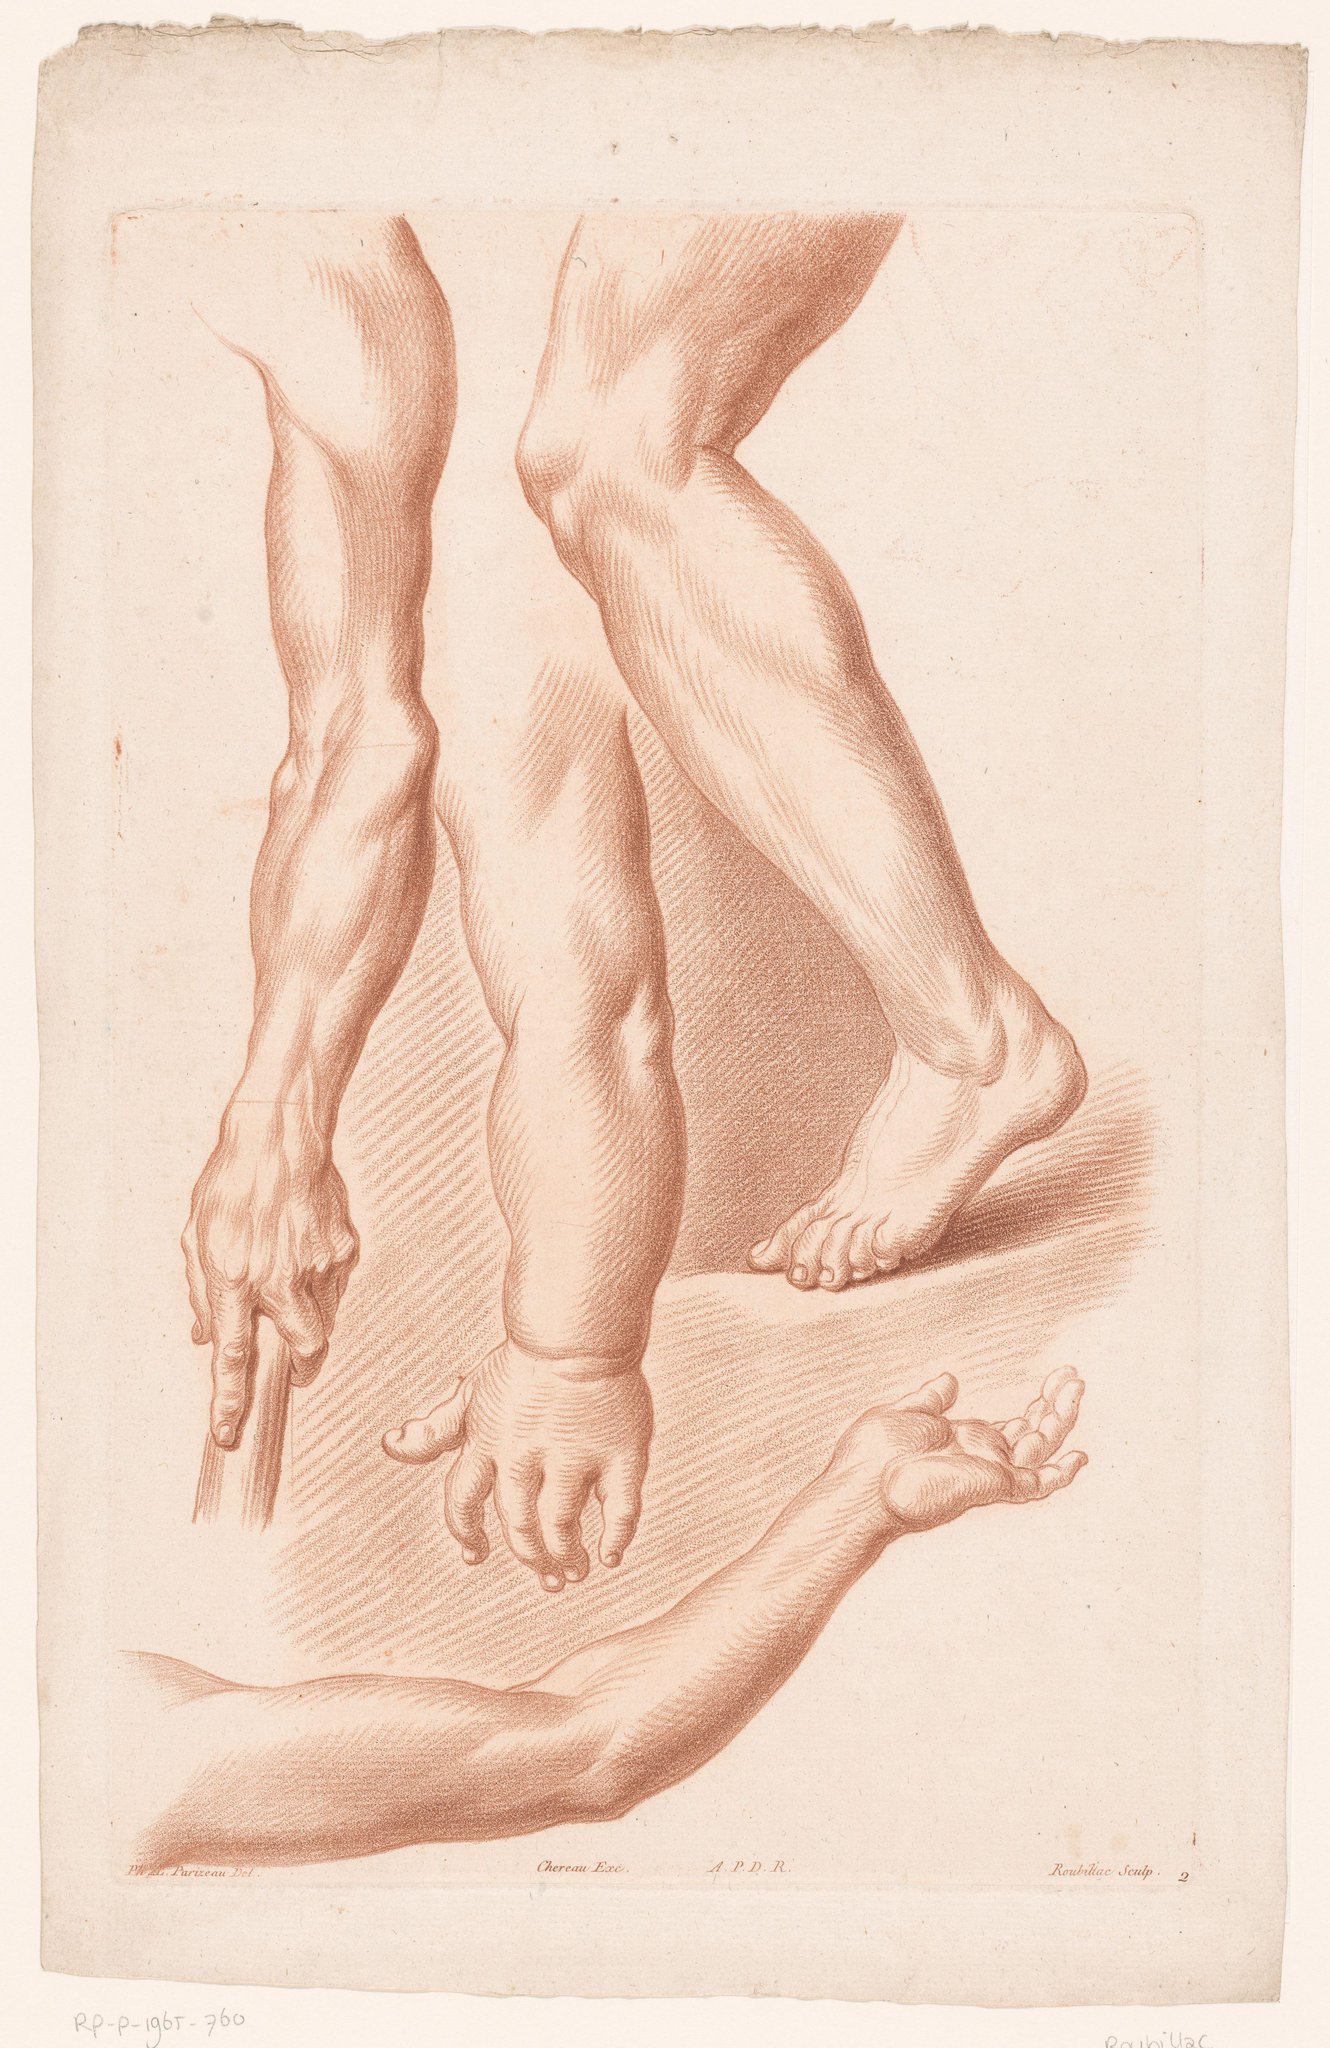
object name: print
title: Verschillende aanzichten van een been en drie armen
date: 1780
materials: paper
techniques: printmaking, etching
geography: france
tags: drawing, sketch, legs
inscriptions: collector's mark: Lugt 2228